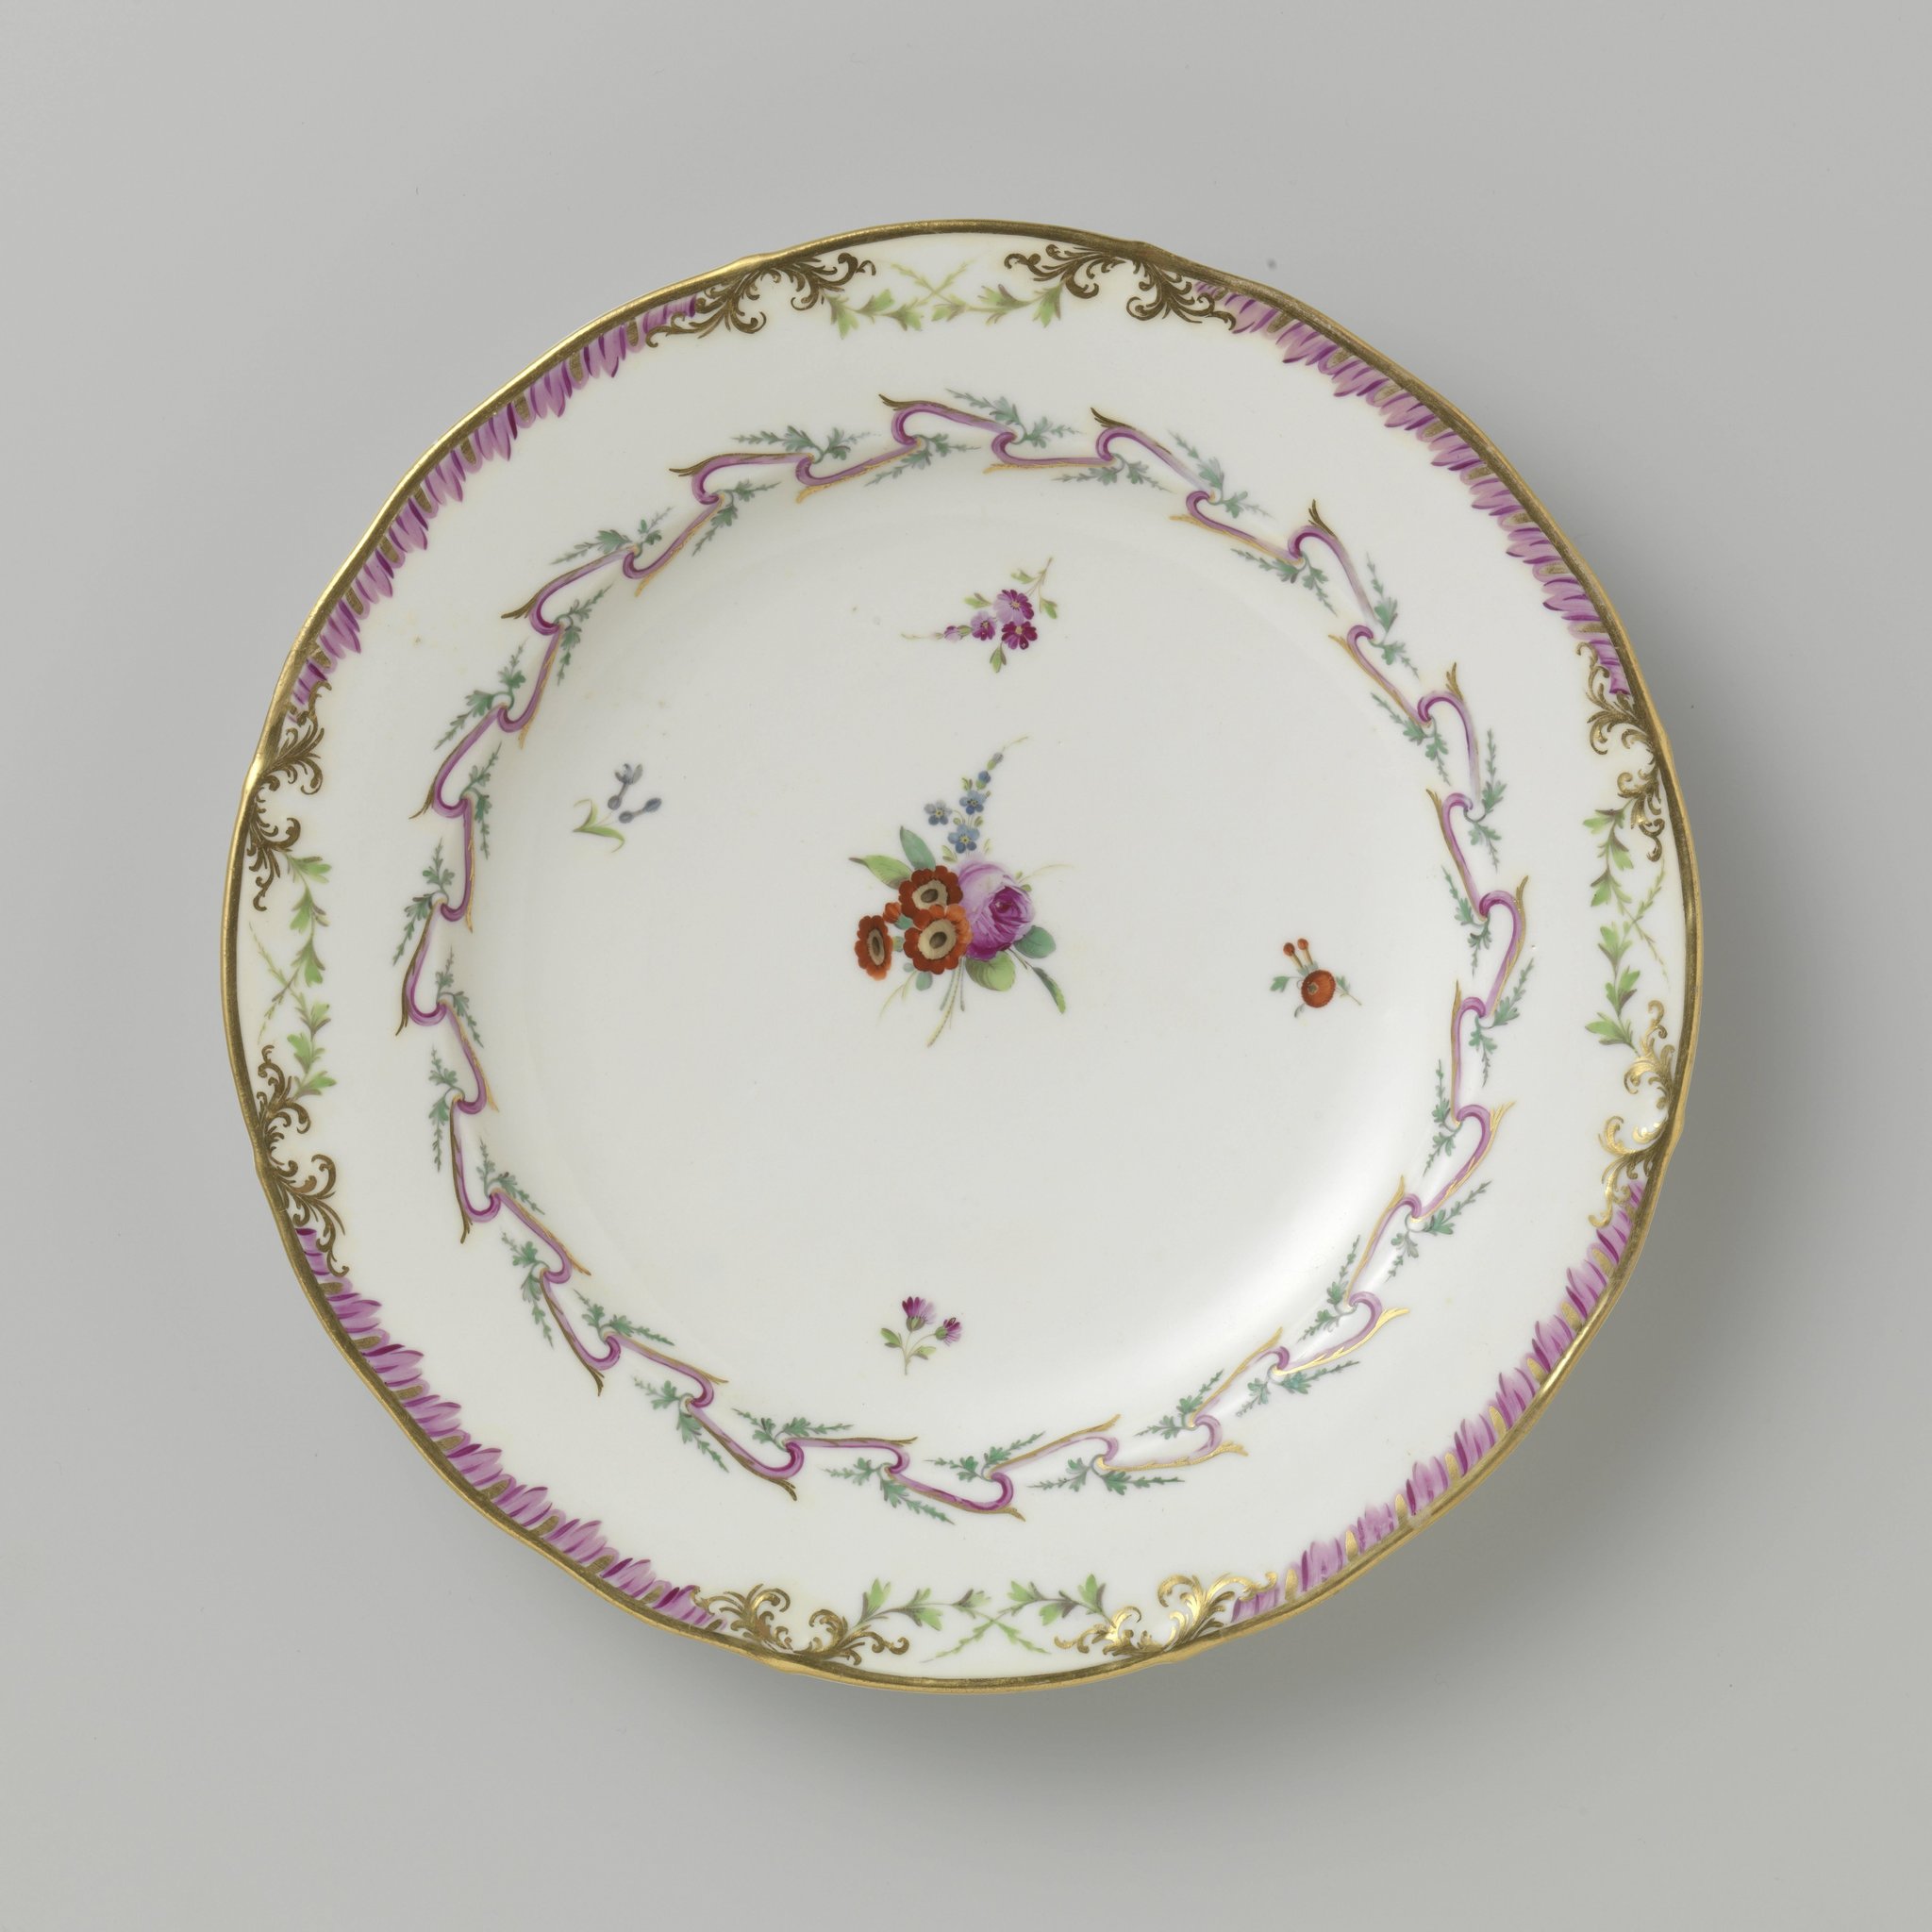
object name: plate dish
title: Bord, plat model, behorend bij een servies met geslingerd lintmotief met bladertakken, bloemboeketten en gestrooide bloemtakken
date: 1780-1820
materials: porcelain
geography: amsterdam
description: Bord, plat model, behorend bij een servies van porselein met geslingerd lintmotief in paars en goud met groene bladertakken, bloemboeketten en gestrooide bloemtakken. Randen lichtgegolfd met decoratie in goud met paars bladmotief waartussen groen gekruist bladmotief. Gemerkt: M.O.L. of AMSTEL.